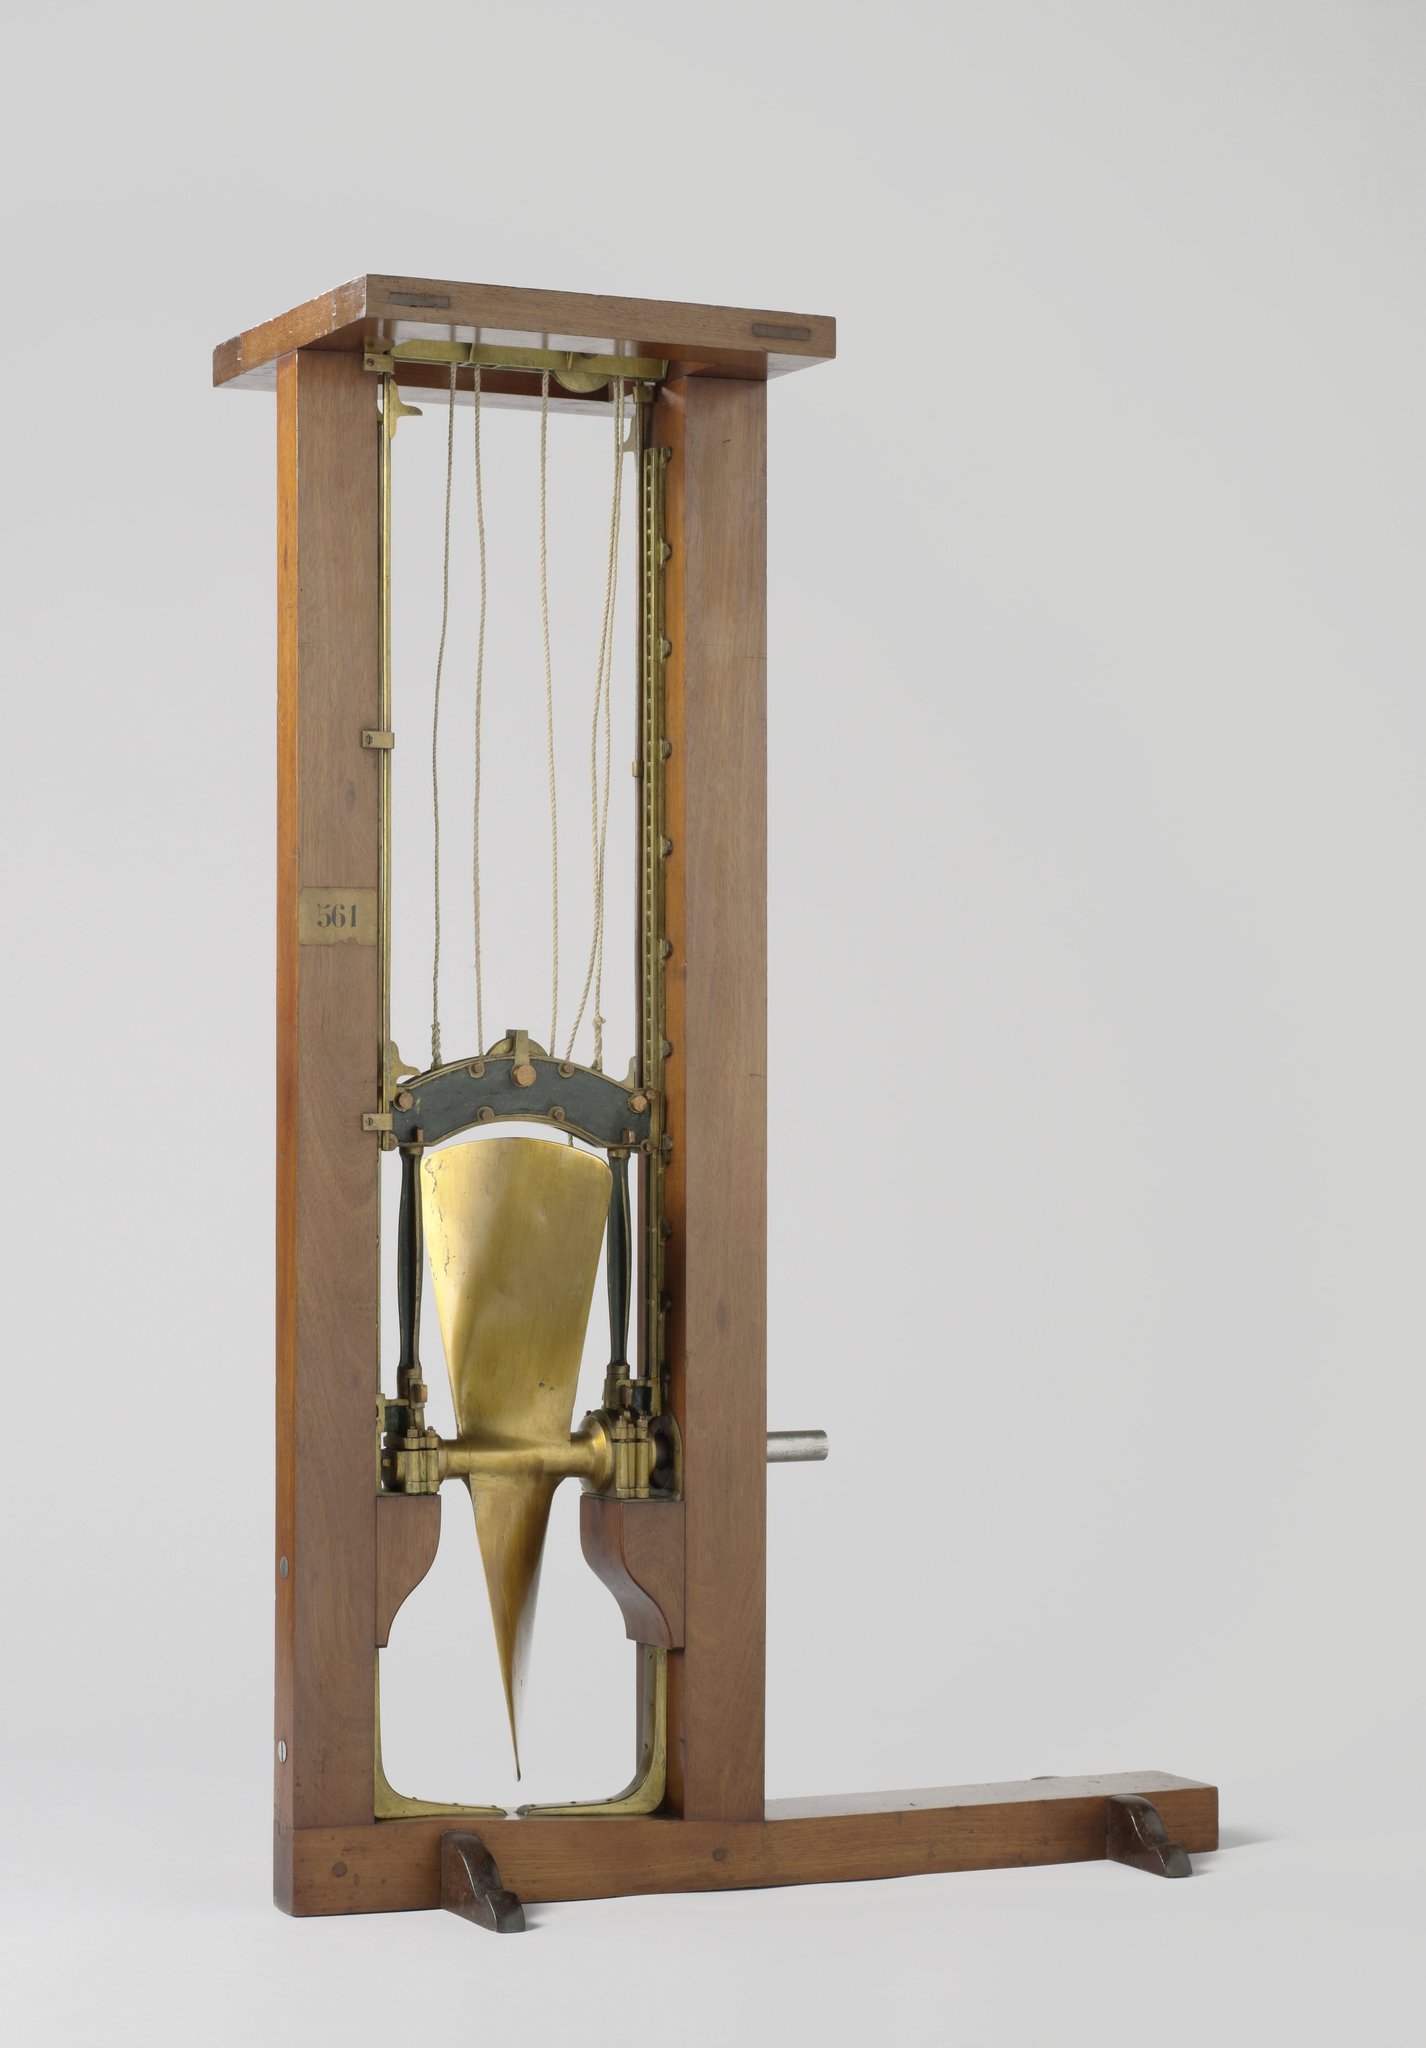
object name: demonstration model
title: Model of a Lifting Screw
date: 1853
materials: brass, iron, fiber, wood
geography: amsterdam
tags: medusa (schip), shimonoseki, straat van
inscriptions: label, on the frame: ‘561’ former inventory label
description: Model van een schroefkoker tussen achtersteven en roersteven, met een deel van de kiel. Het schroeflichttoestel bestaat uit een los metalen frame met een gewone tweebladige schroef, dat in de koker op en neer gehesen kan worden aan een touw, dat loopt over een schijf boven in de schroefkoker en een schijf in het schroefraam. Hiervoor moet eerst de schroefas teruggetrokken worden. Het schroefraam beweegt over verticale rails tegen de achtersteven en de schroefsteven, die zijn voorzien van tanden; hierin vallen pallen van het schroefraam die het terugglijden voorkomen. De pallen kunnen door aan twee touwen te trekken worden teruggehouden, zodat het schroefraam kan zakken. Klemstangen tegen schroef- en achtersteven kunnen de beweging van het schroefraam blokkeren. De mik die het draaien van de schroef bij het hijsen belet, ontbreekt. Schaal 1:10 (afgeleid).